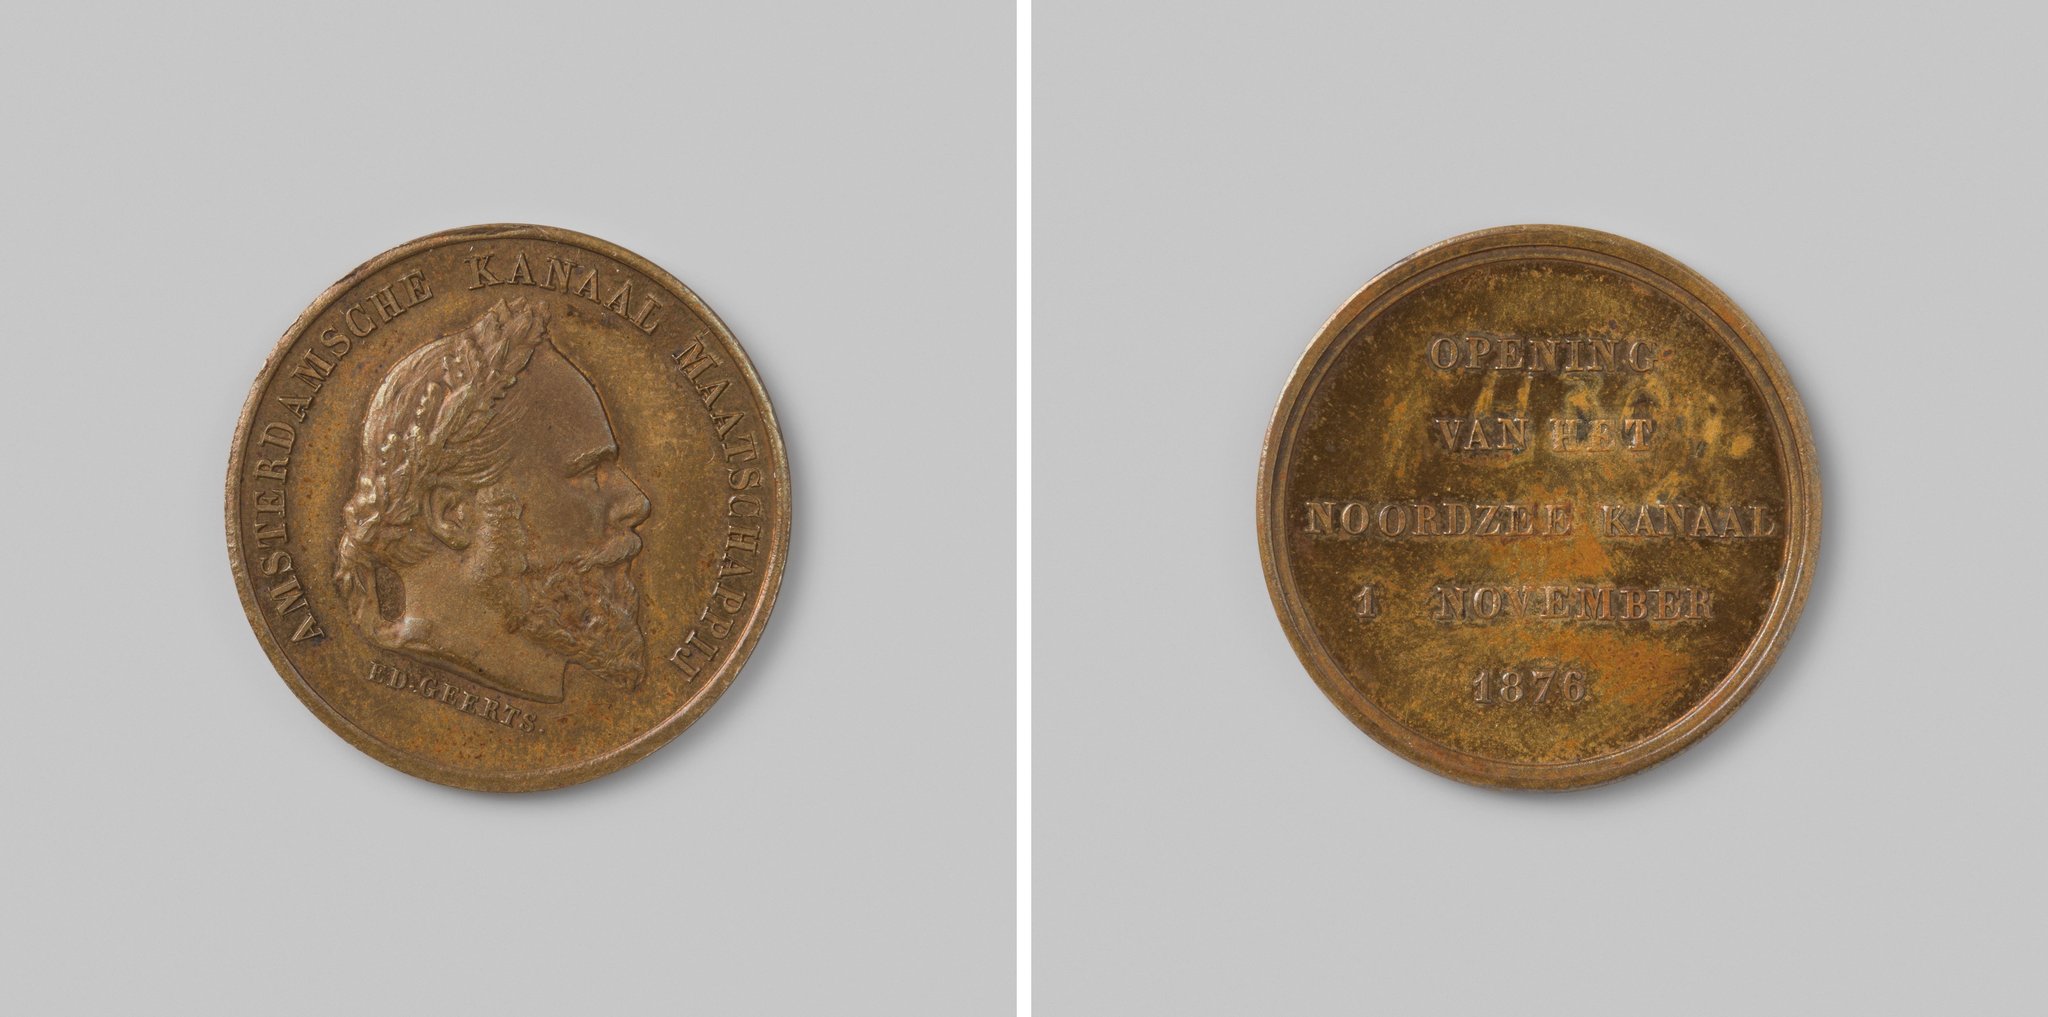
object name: history medal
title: Opening van het Noordzeekanaal, ter ere van Willem III, koning der Nederlanden, penning geslagen op last van de Amsterdamsche Kanaal Maatschappij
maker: edouard louis geerts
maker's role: medailleur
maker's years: 1846-1889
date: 1876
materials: copper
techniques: striking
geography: brussels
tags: brussels, willem iii (koning der nederlanden)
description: Koperen penning. Voorzijde: borststuk man met eikekrans binnen omschrift. Keerzijde: opschrift